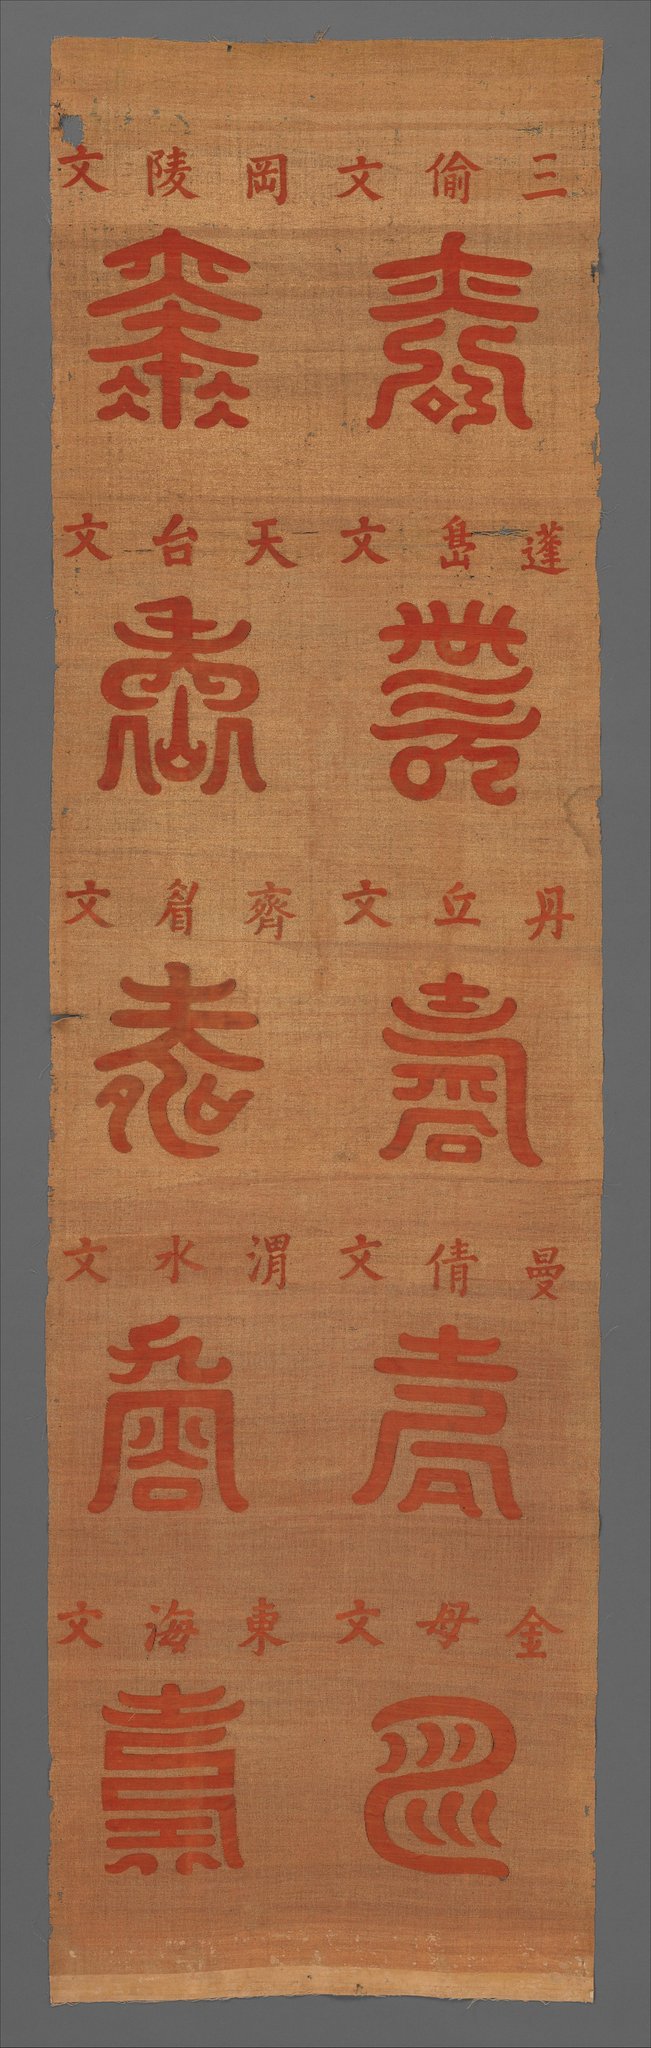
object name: piece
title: Panel with Longevity (Shou) Characters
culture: chinese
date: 1801-1900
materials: metal thread, silk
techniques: tapestry